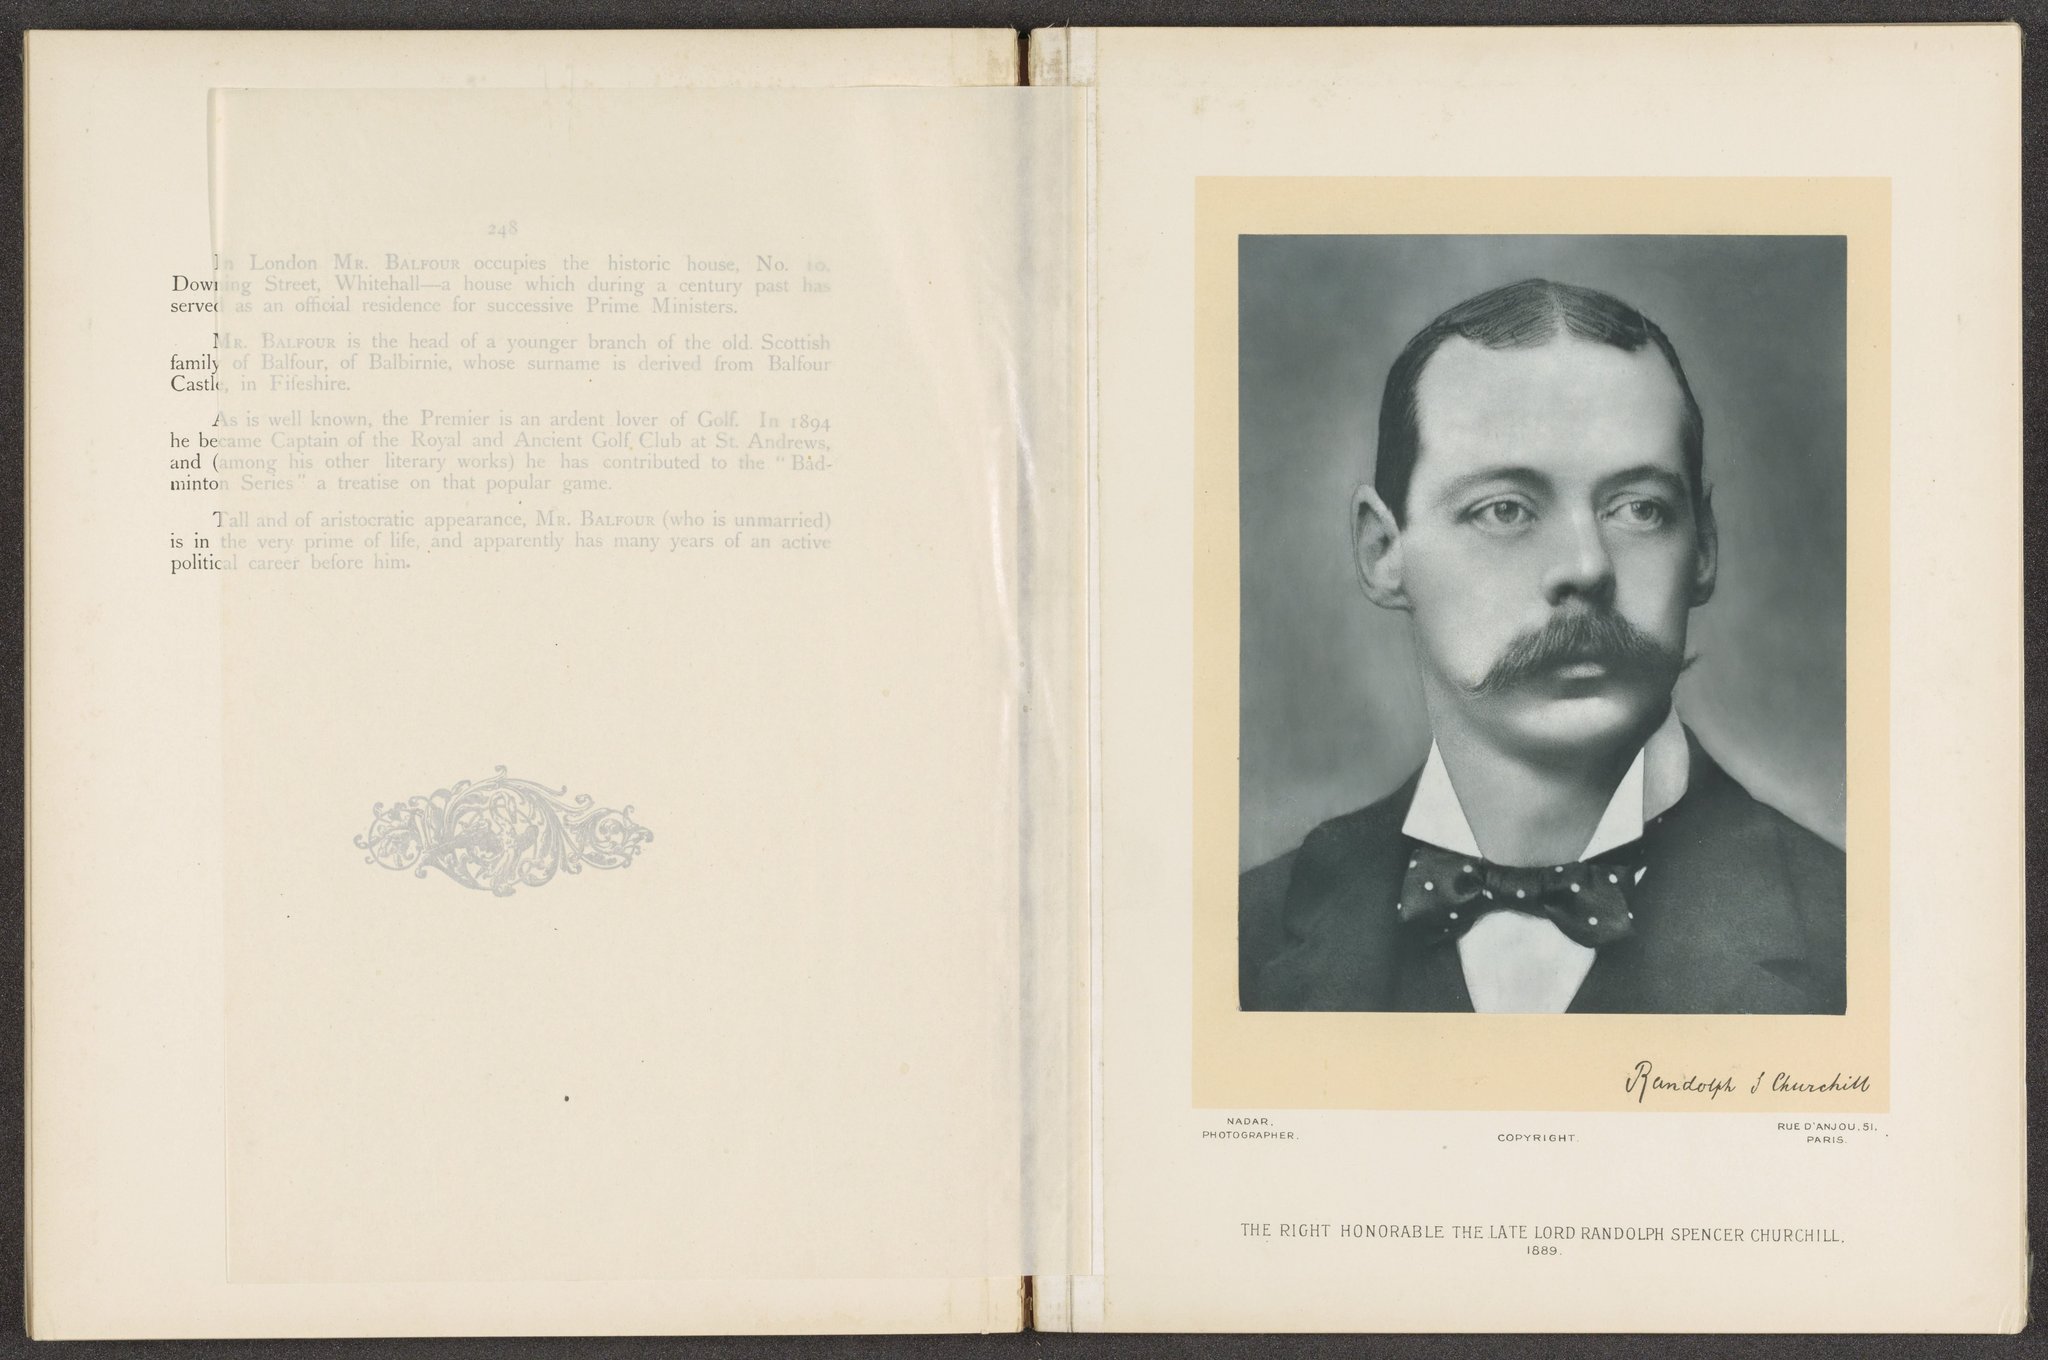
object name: page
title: The right honorable the late lord Randolph Spencer Churchill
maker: félix nadar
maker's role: ballonvaarder, fotograaf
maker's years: 1820-1910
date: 1890-1895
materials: paper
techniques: carbon print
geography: paris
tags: politician, historical persons (portraits and scenes from the life) (+ (full) bust portrait)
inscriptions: annotation, inscription: ‘Rue d'Anjou, 51, Paris.’